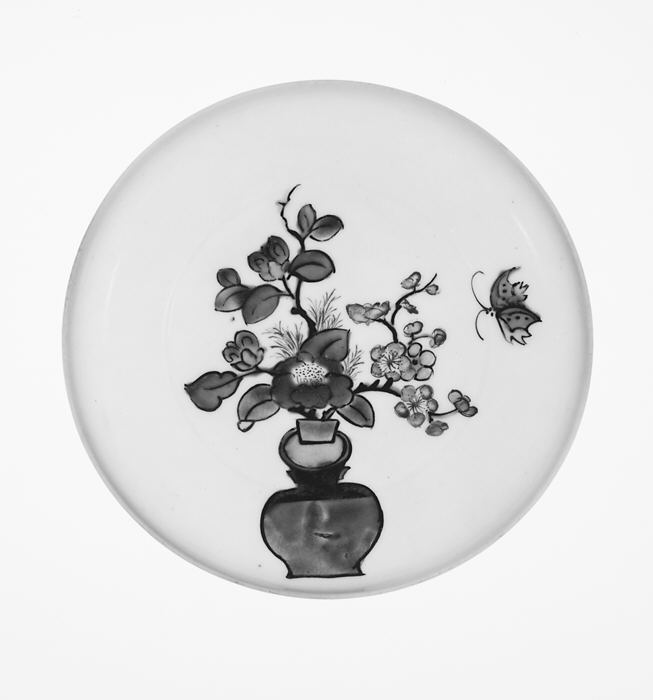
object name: dish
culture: japanese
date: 1615-1868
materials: enamel, porcelain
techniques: painting, polychrome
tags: butterflies,flowers